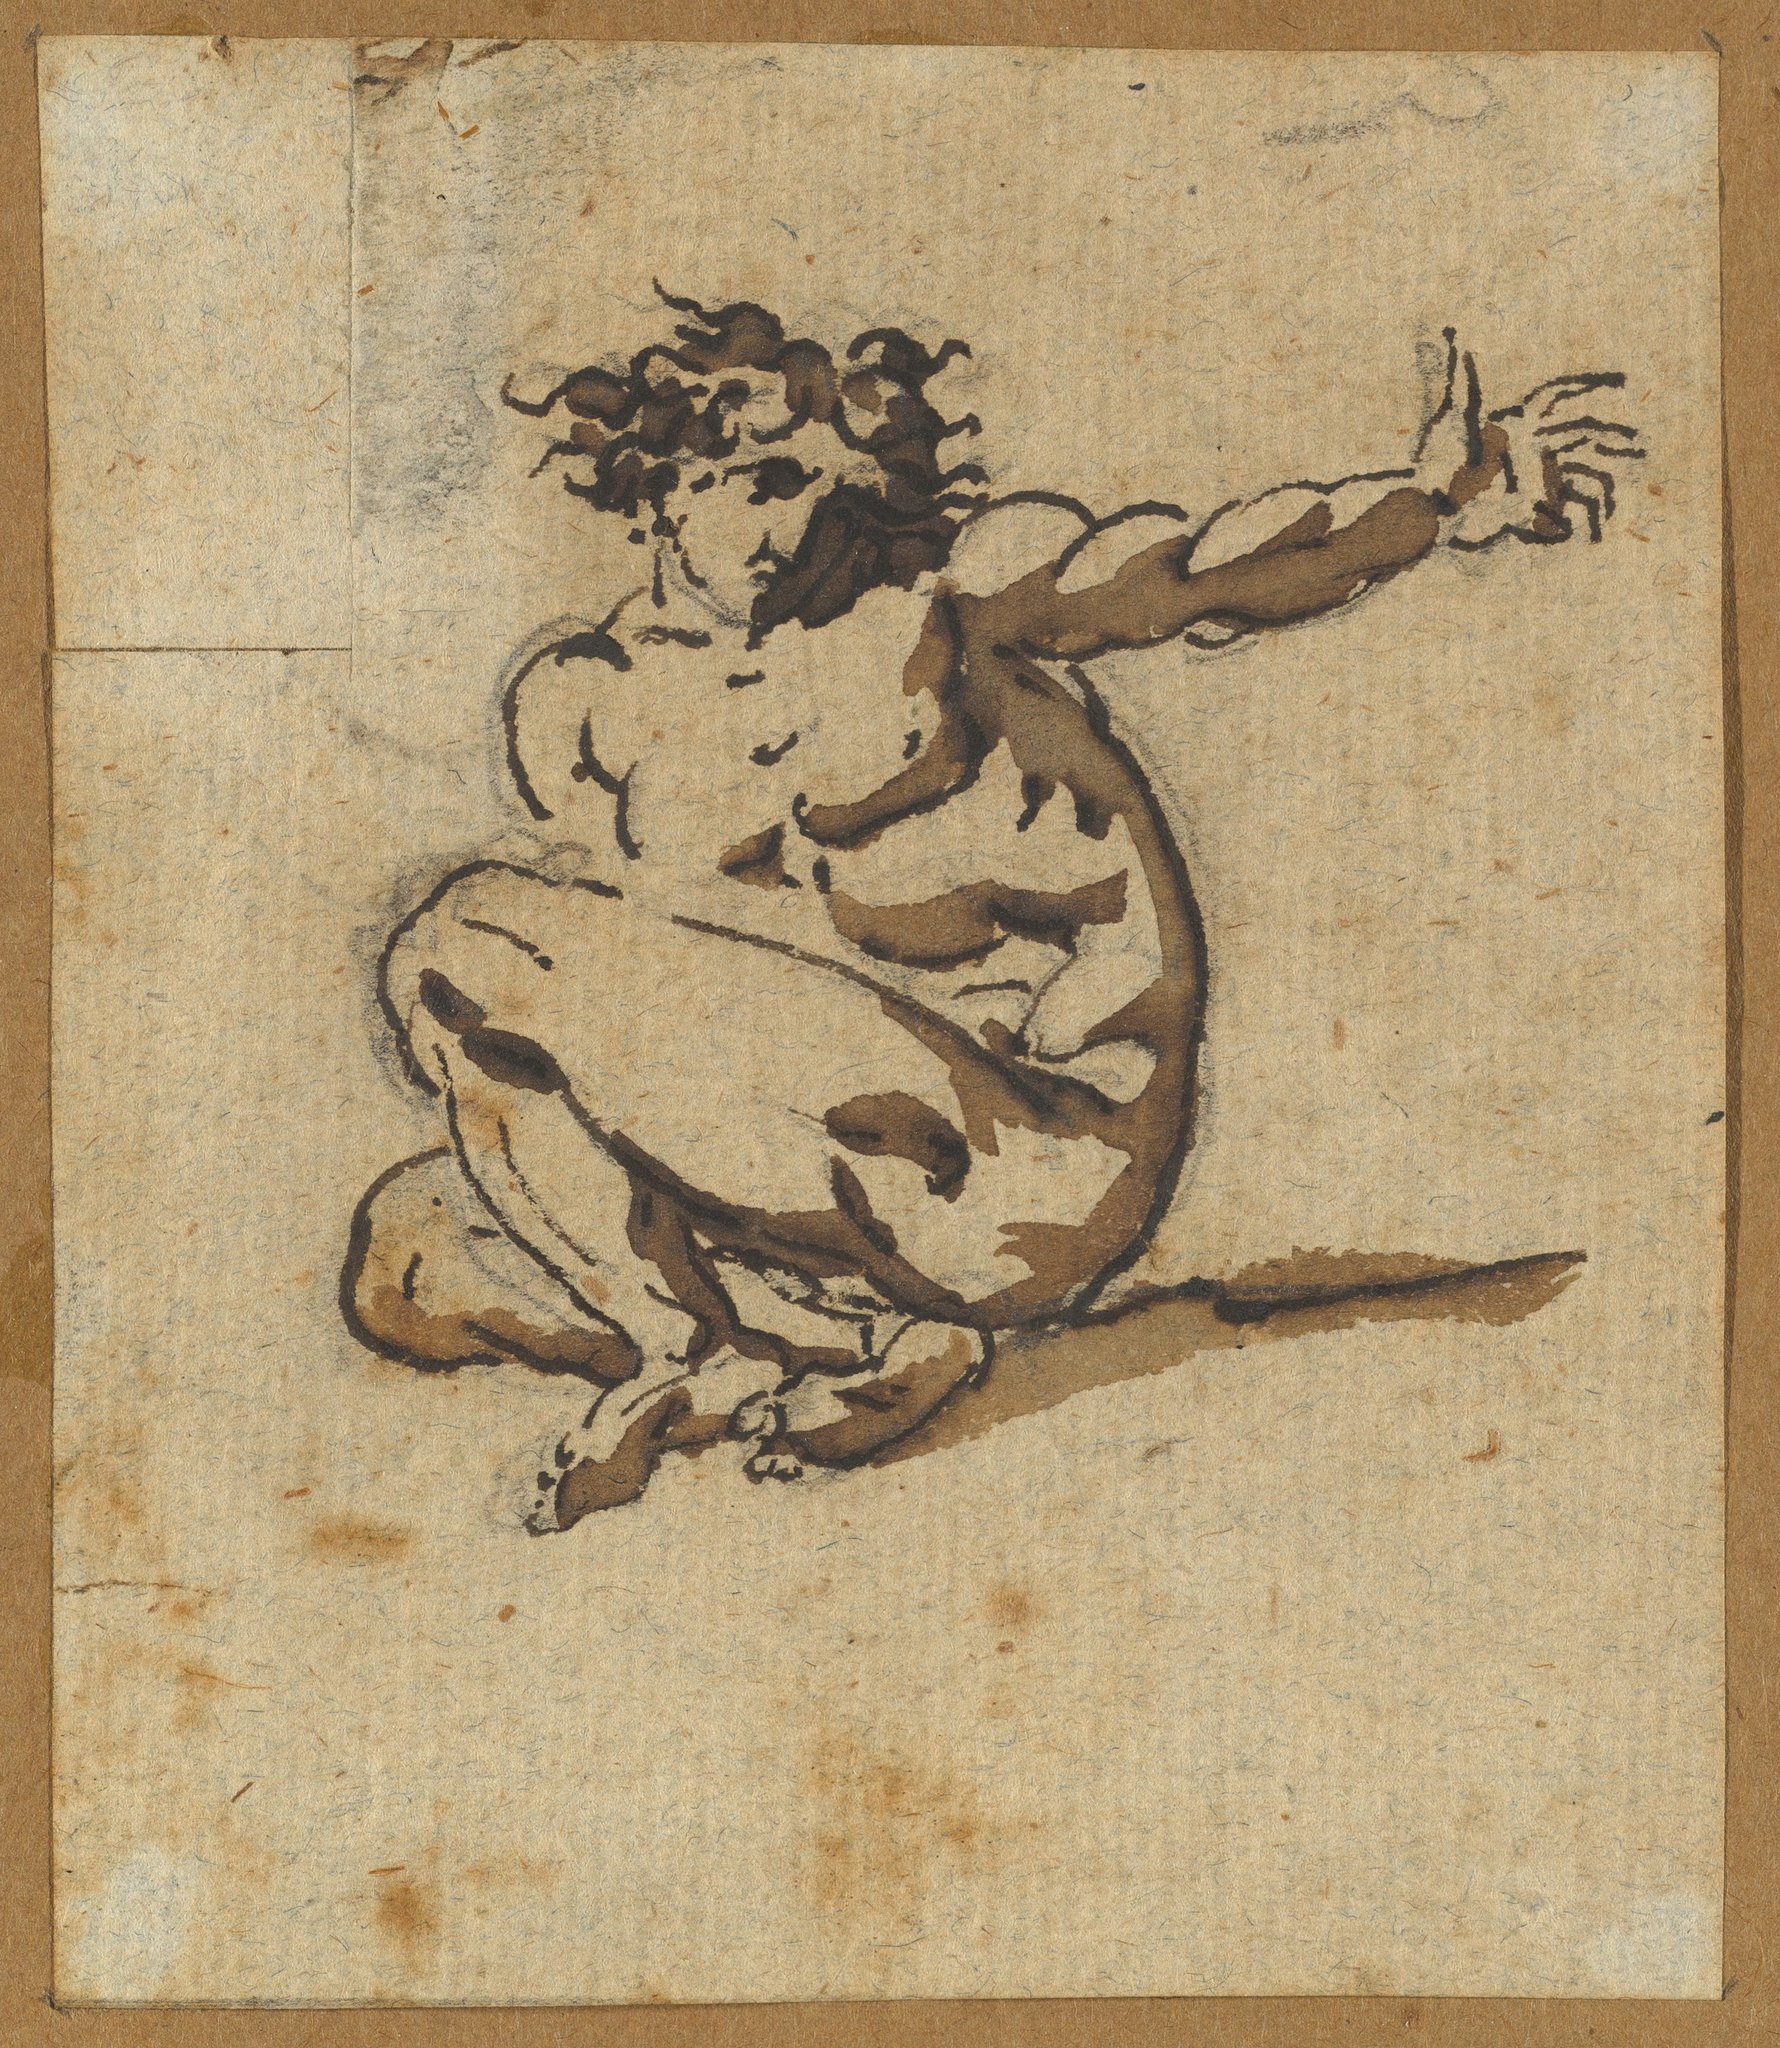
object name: drawing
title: Study of a Male Nude (Althaemenes) in Despair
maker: nicolai abraham abildgaard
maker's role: artist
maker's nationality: danish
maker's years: 1743-1809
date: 1734-1833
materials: graphite, ink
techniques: pen, wash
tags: male nudes